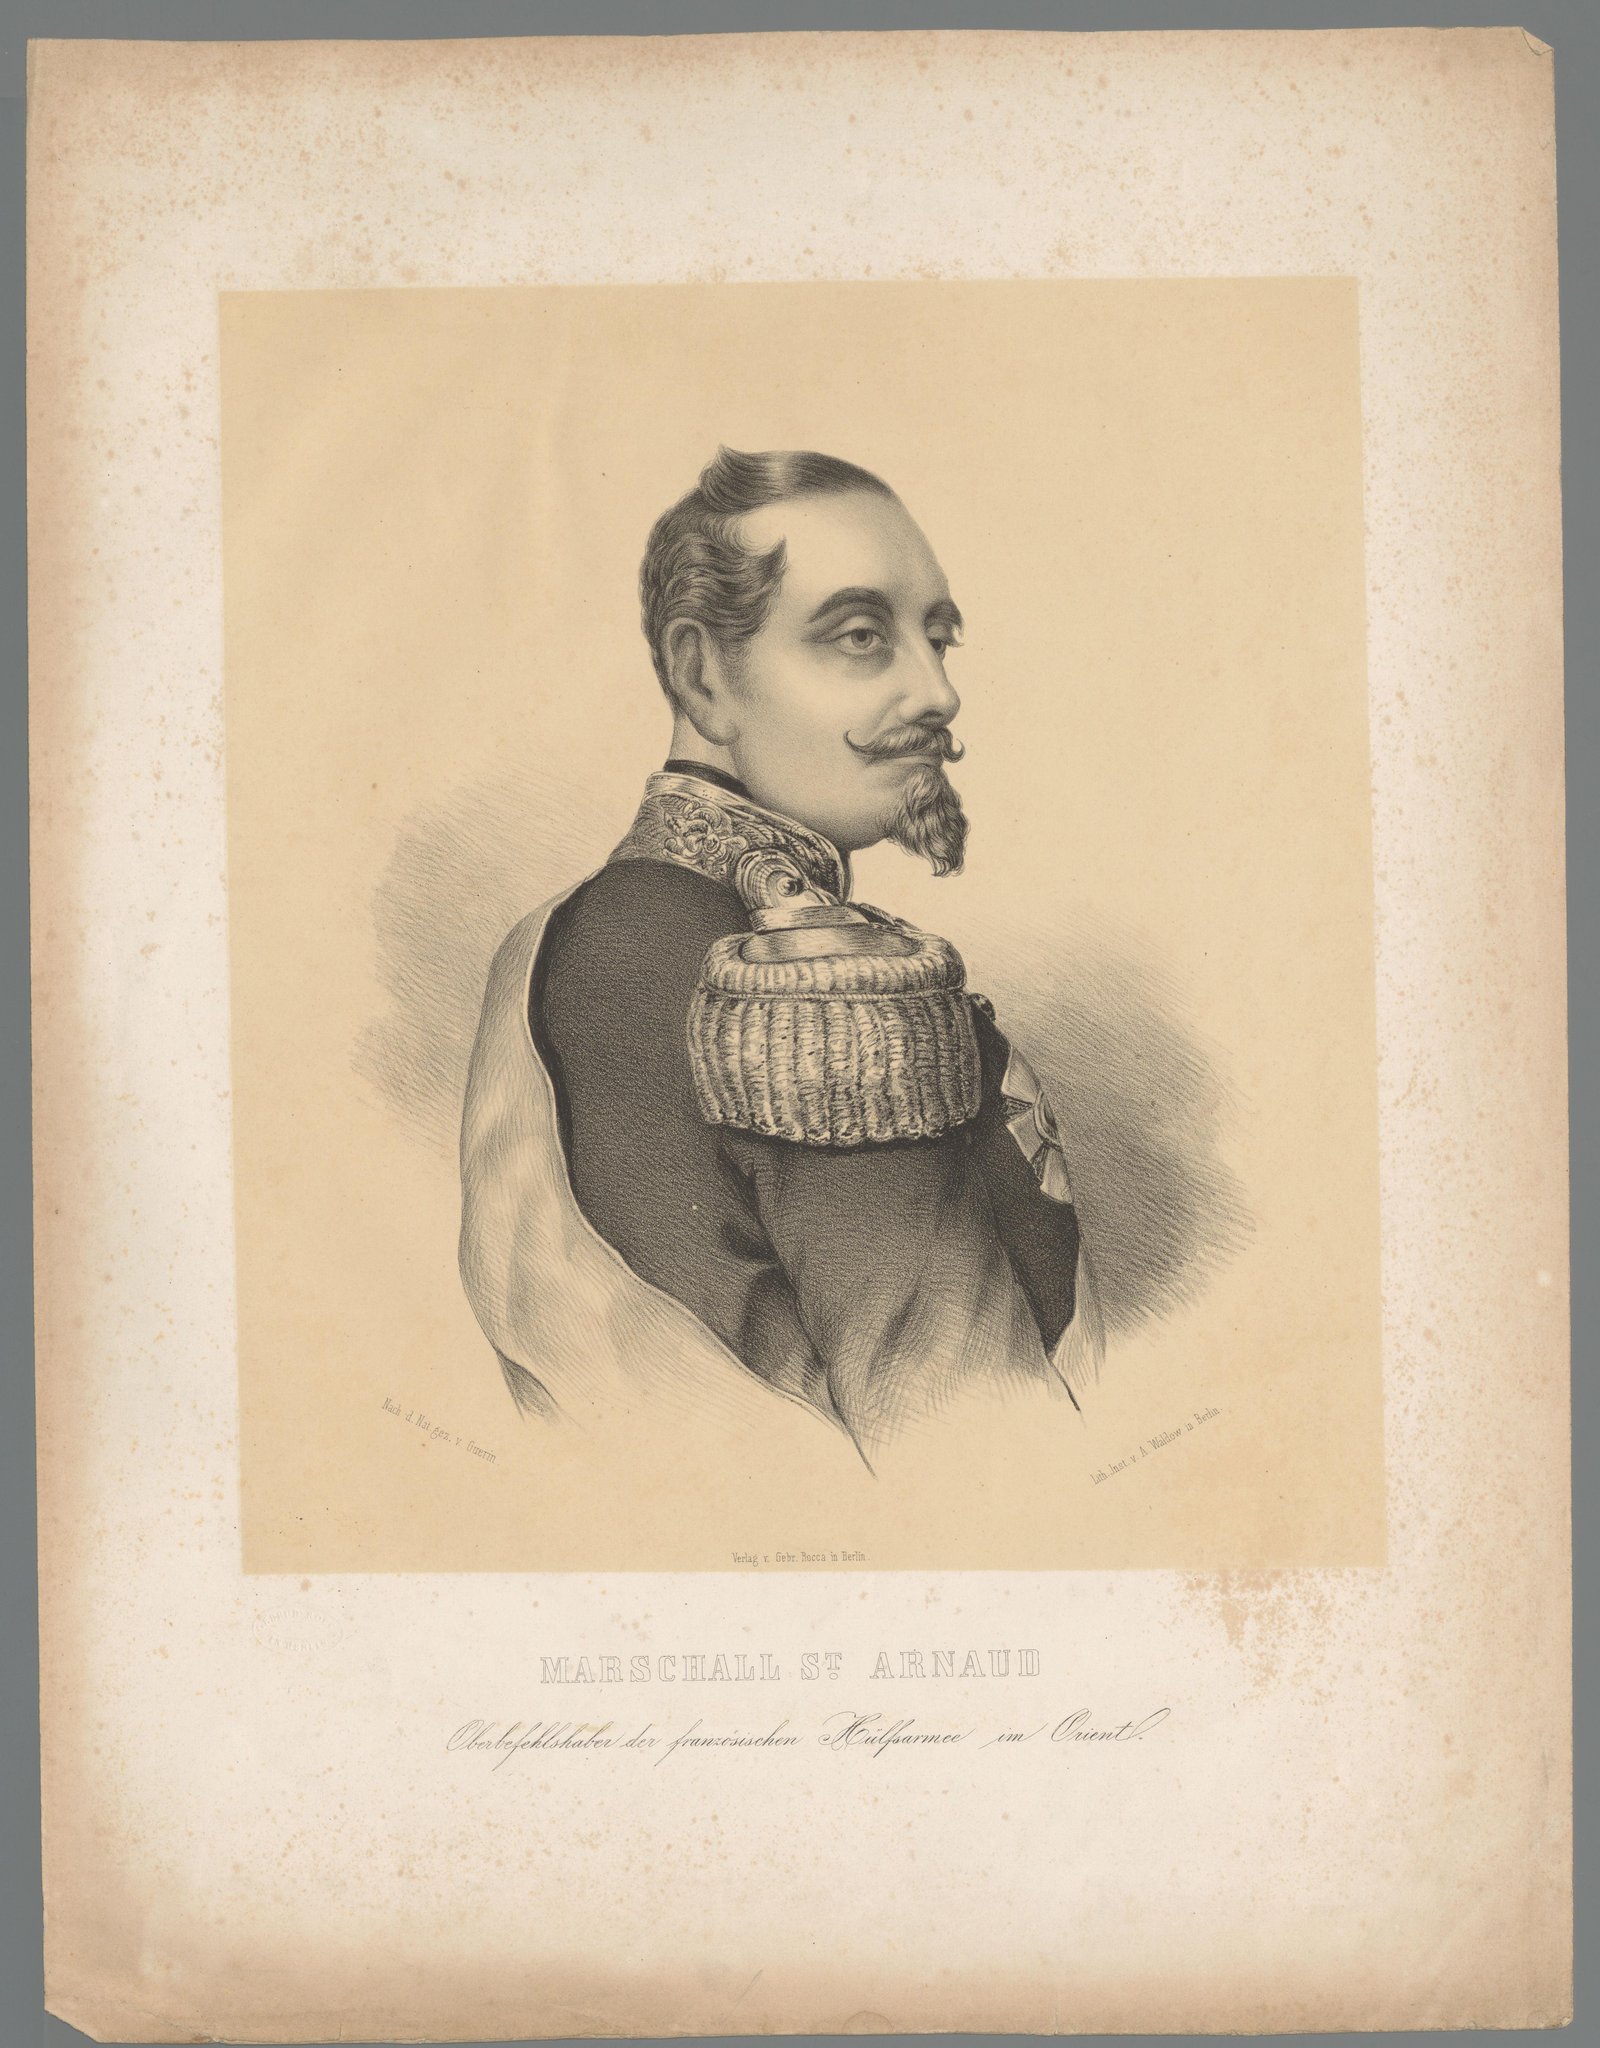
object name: print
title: Portret van Jacques Leroy de Saint-Arnaud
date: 1830-1863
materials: paper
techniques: tone lithography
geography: berlin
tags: paris, commander-in-chief, general, marshal, adult man, historical persons, beard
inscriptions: collector's mark: Lugt 2228, check stamp: Lugt 2141c